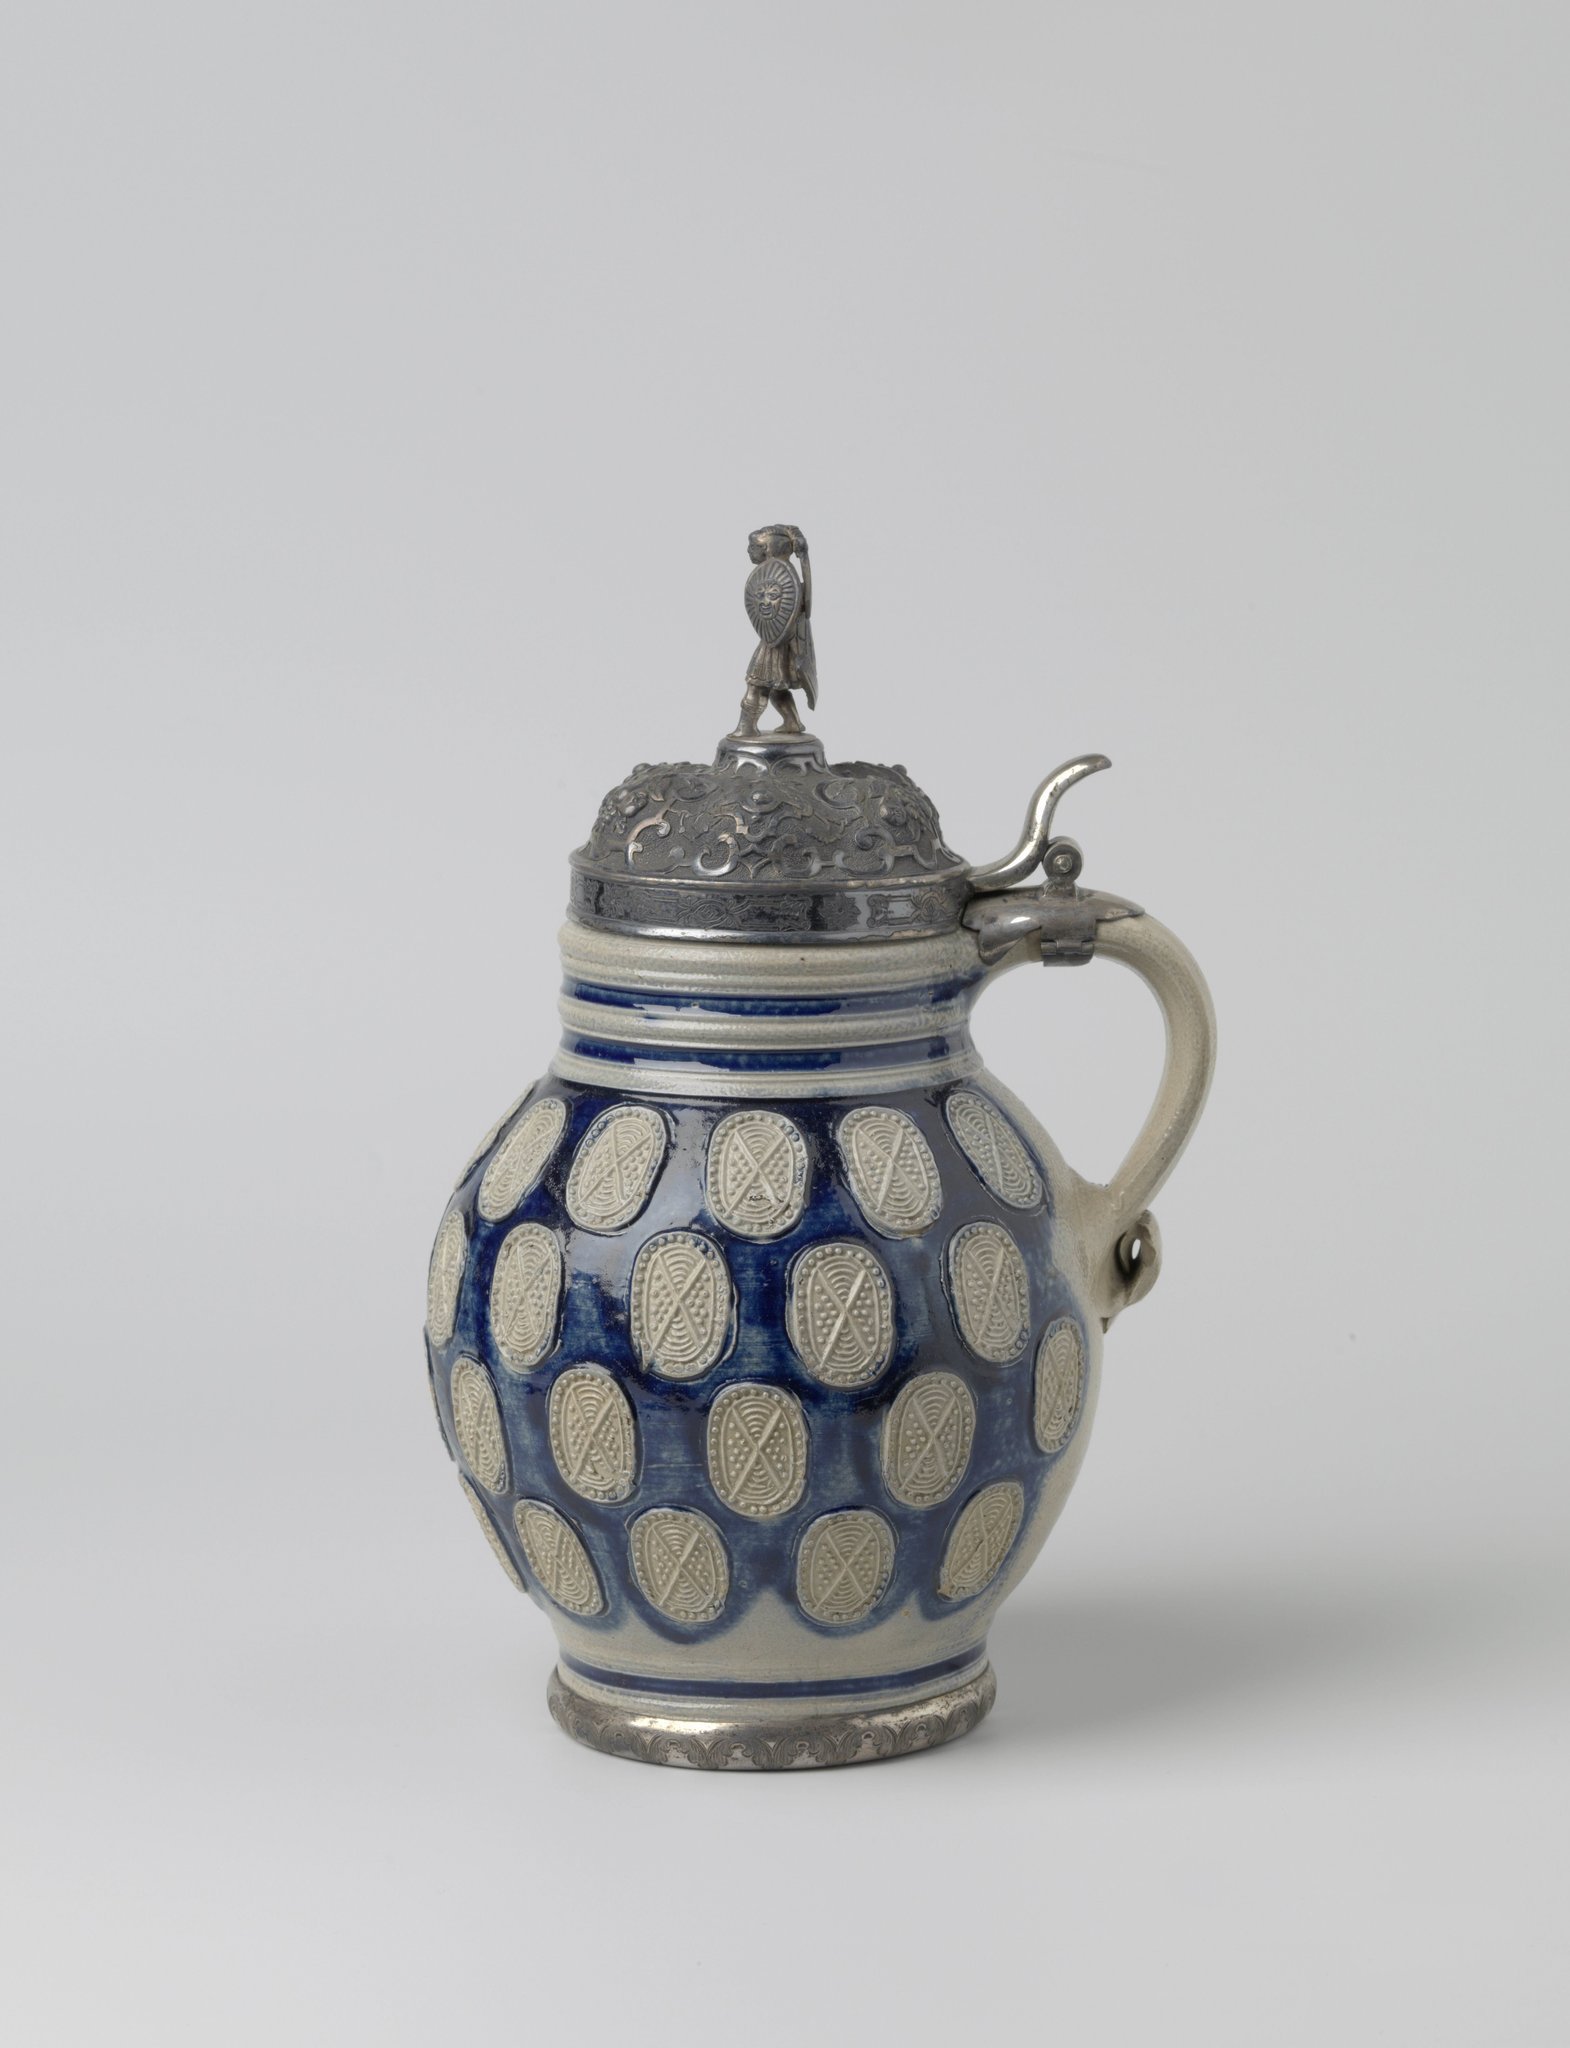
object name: jug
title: Jug with medallions and silver mount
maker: Anonymous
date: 1650-1724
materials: cobalt, glaze, silver, stoneware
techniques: firing, forming, relief, turning, vitrification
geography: westerwald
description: Kruik van steengoed op hoge voet met een bolvormige lichaam en wijde nek. Het C-vormige oor is bevestigd aan de nek en de schouder. Enkele profielen en ingegrifte lijnen op de nek en voet. Gedeeltelijk bedekt met kobaltblauw. Op de buik gedrukte en opgelegde medaillons in reliëf. Het medaillon is in vieren verdeeld door middel van een kruis, met in elk vak afwisselend stippen of strepen. Bevestigd aan het oor een rijkversierd zilveren montuur met zes bobbels in de deksel met fruittakken en ornamenten. De bekroningen in de vorm van een Romeinse soldaat. Op de voet een zilveren band met bladranken. Het montuur is van later datum. Westerwald.